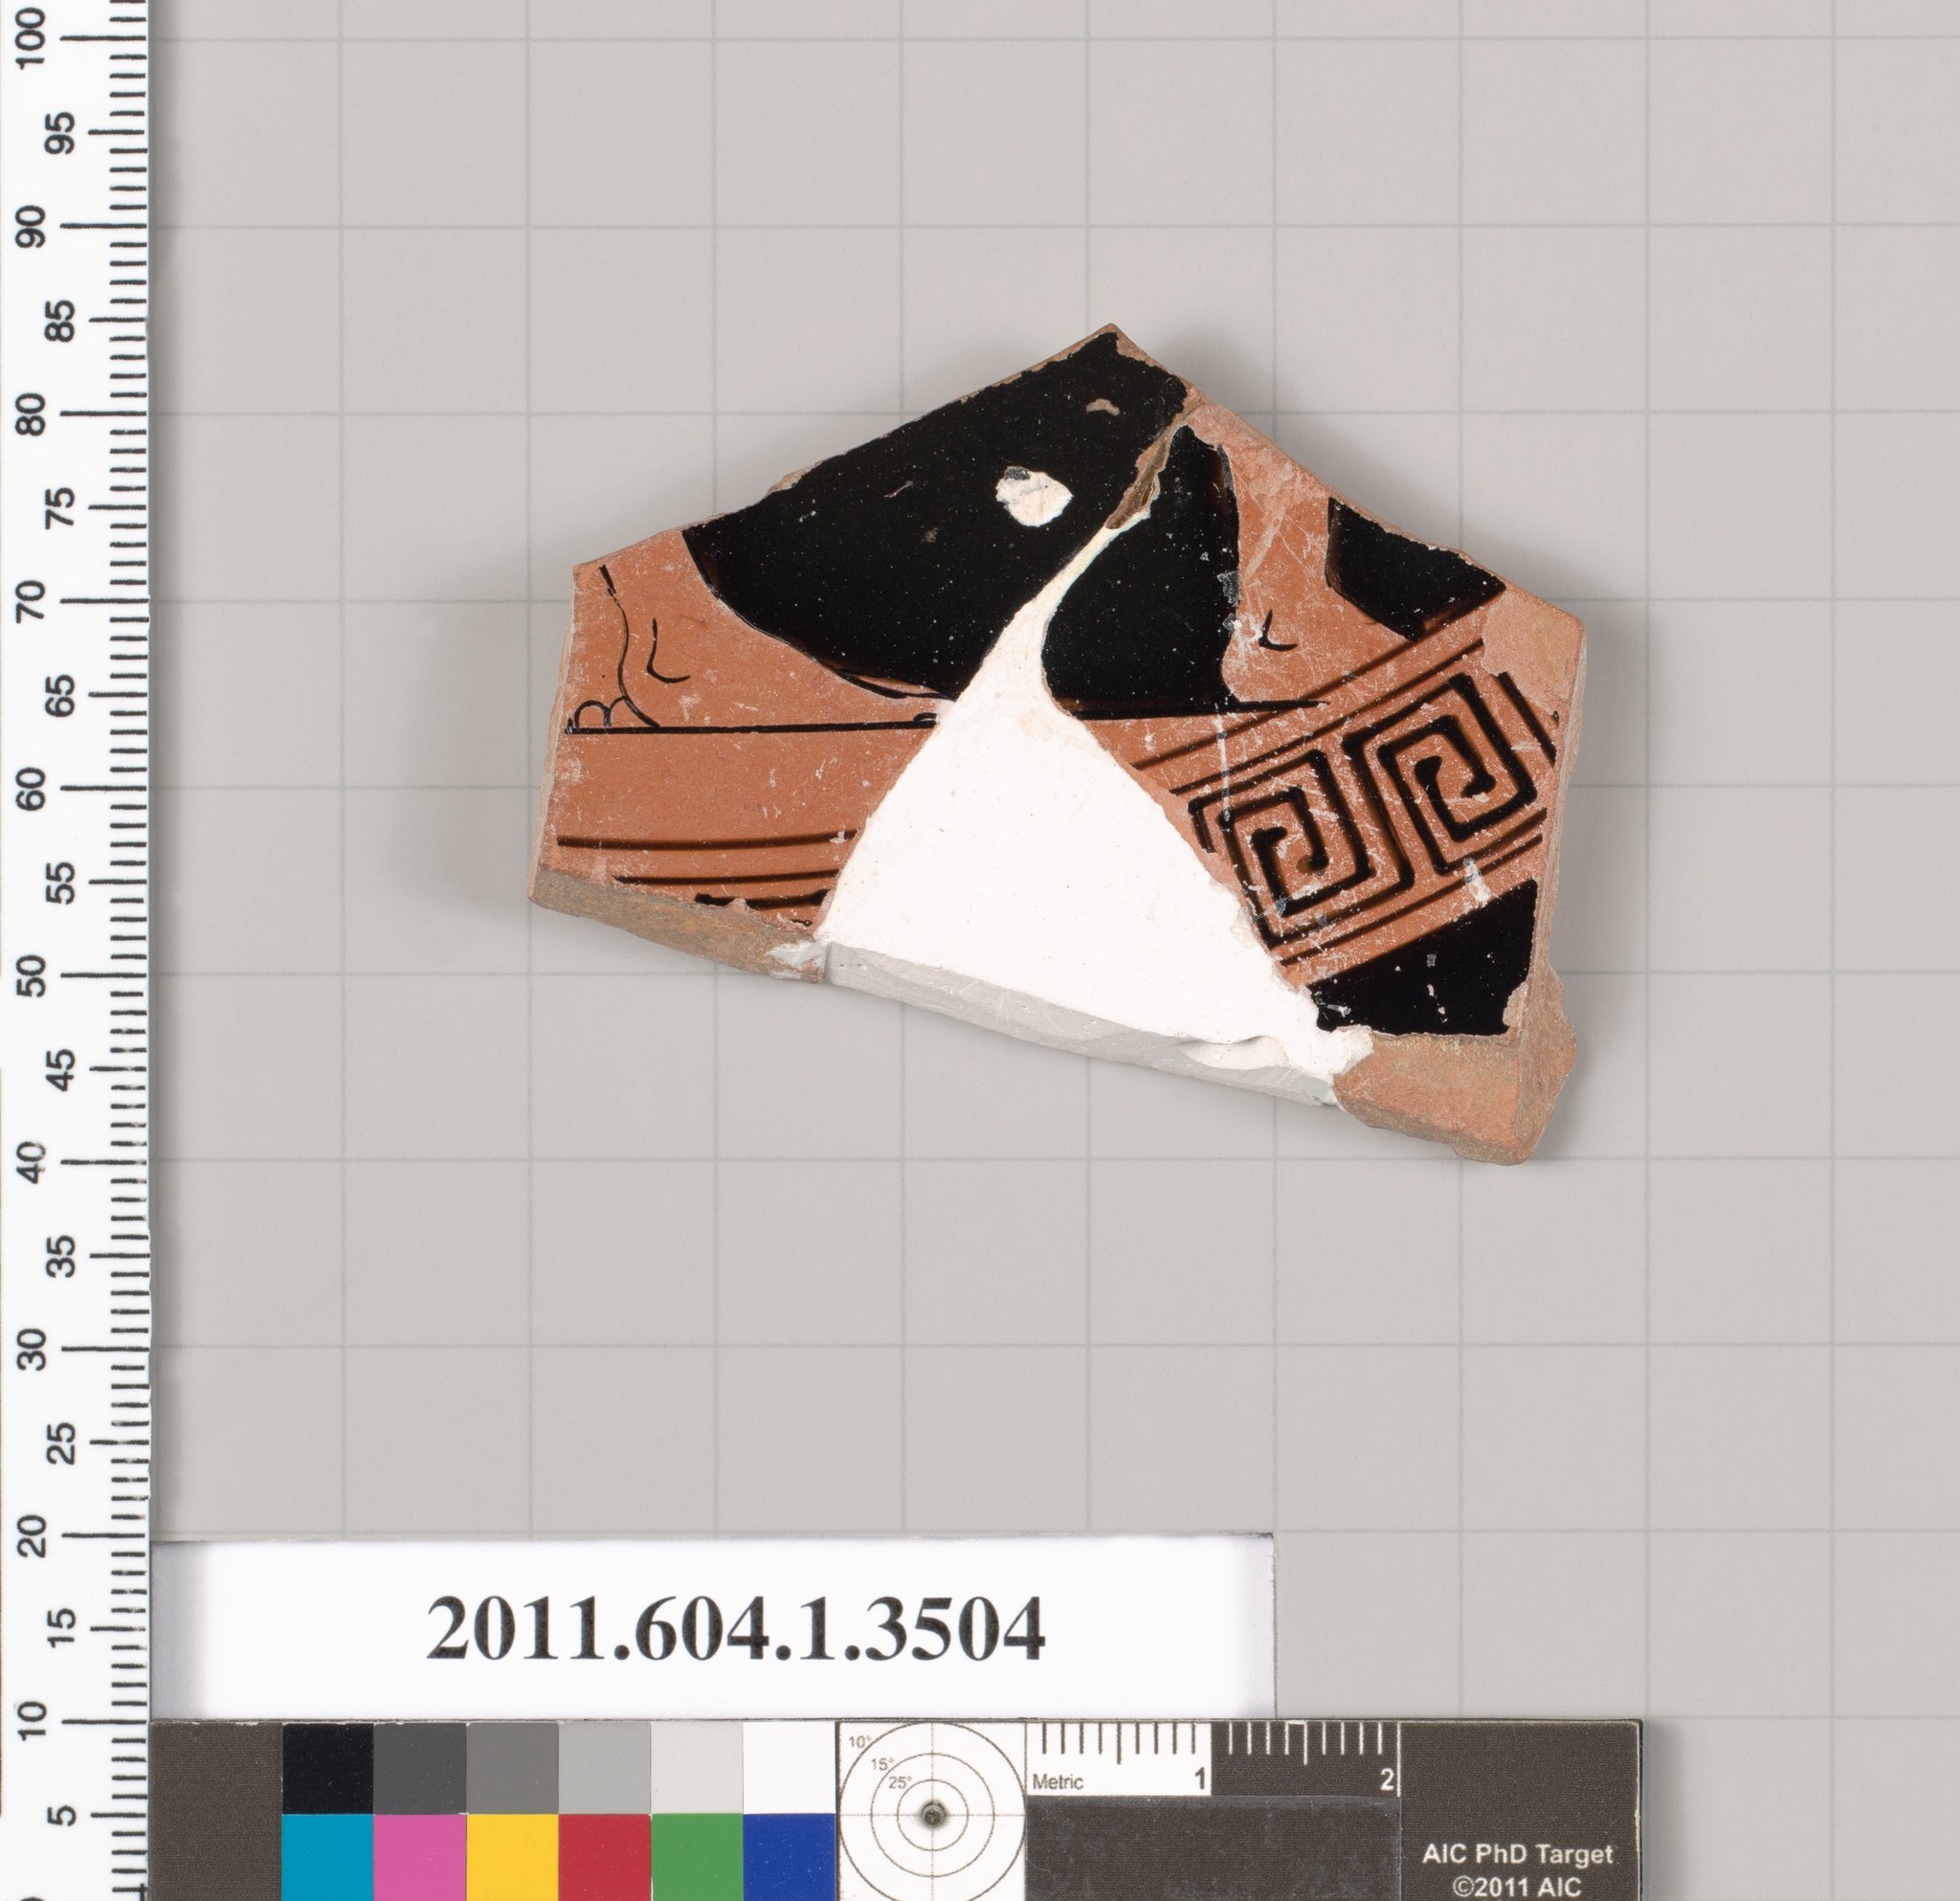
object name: kylix fragment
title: Terracotta fragment of a kylix (drinking cup)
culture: greek, attic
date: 490-480 BCE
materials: terracotta